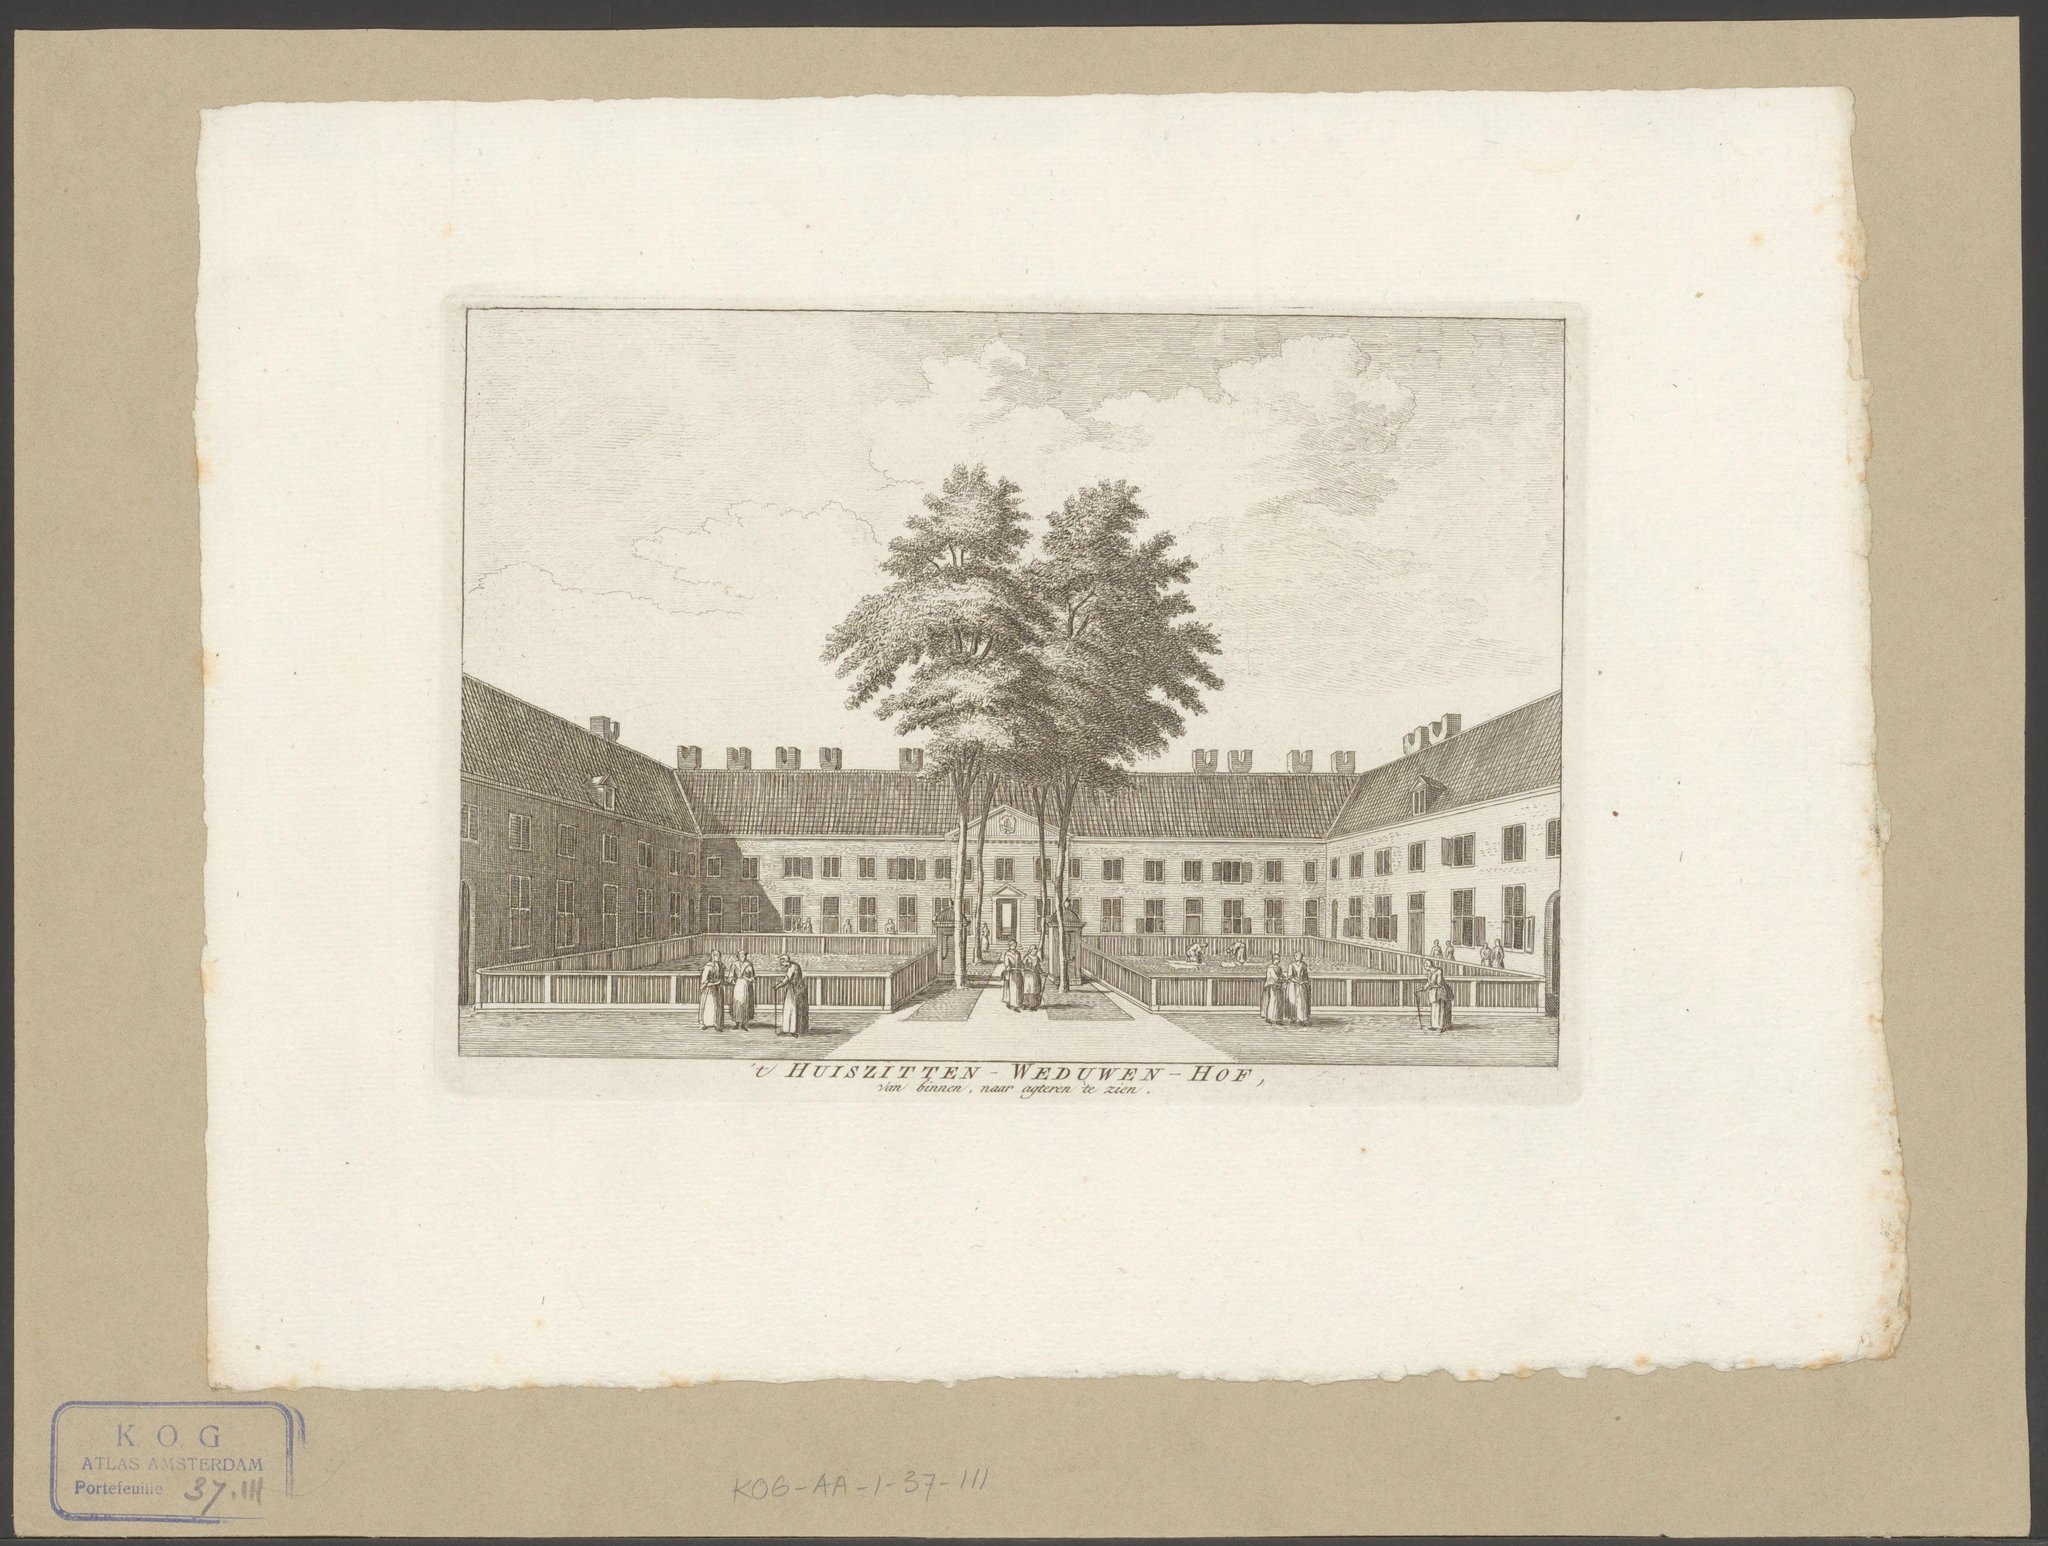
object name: print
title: Gezicht op de binnenplaats van het Huiszittenweduwenhof (Kartuizerhof) te Amsterdam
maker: Anonymous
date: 1765-1782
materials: paper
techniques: engraving, etching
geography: northern netherlands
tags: poorhouse, courtyard, old-people's home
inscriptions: collector's mark: Lugt 1641b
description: Afdruk van de volledige plaat ook gebruikt in: Wagenaar, Jan. Amsterdam, in zyne opkomst, aanwas, geschiedenissen (…). Amsterdam: Isaak Tirion, 1765, dl. 2. En in: Verzameling der fraaiste gezigten van Amsterdam in negen en zeventig afbeeldingen. Amsterdam en Harlingen: Petrus Conradi en Volkert van der Plaats, 1782.